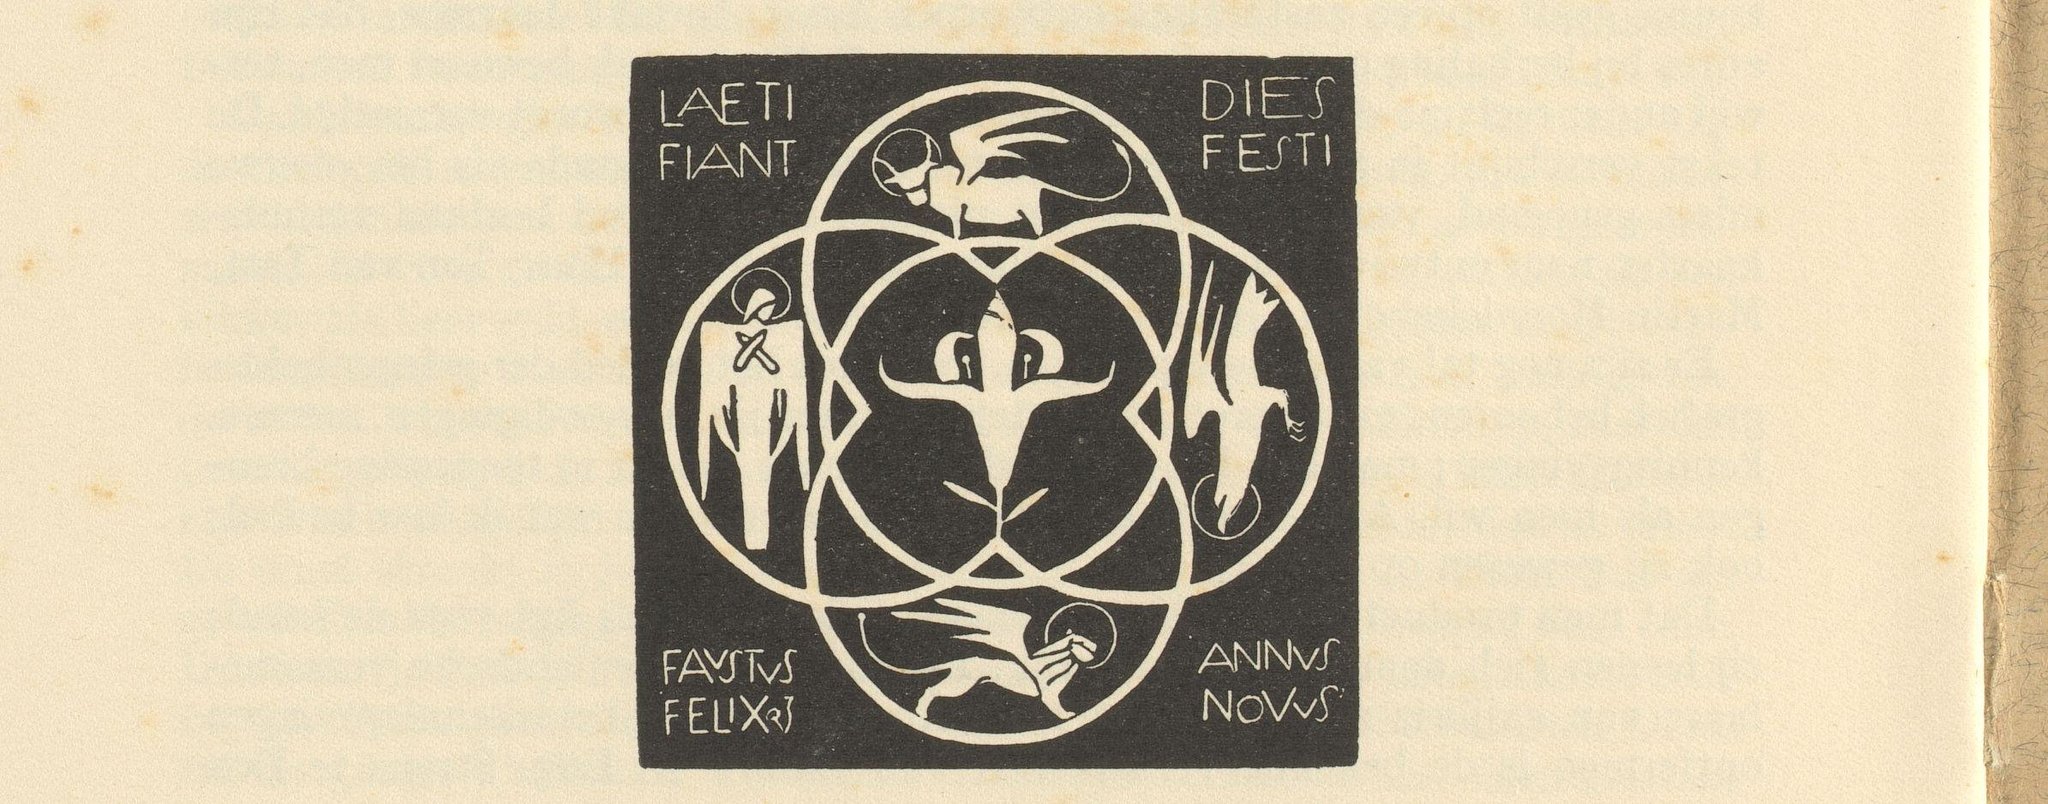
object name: new year card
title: Nieuwjaarswens van Wiktorya Goryńska voor 1931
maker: wiktorya goryńska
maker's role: graficus, houtgraveur, houtsnijder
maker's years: 1902-1945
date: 1930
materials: paper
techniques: woodcut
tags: vienna, wiktorya goryńska, the four symbols of the evangelists, 'the apocalyptic beasts'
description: De vier symbolen voor de evangelisten uit het visioen van de evangelist Johannes op Patmos. Verdeeld over de vier hoeken de tekst: 'Laetie fiant dies festi faustus felix[que] annus novus'. Deze prent maakt deel uit van een boek.